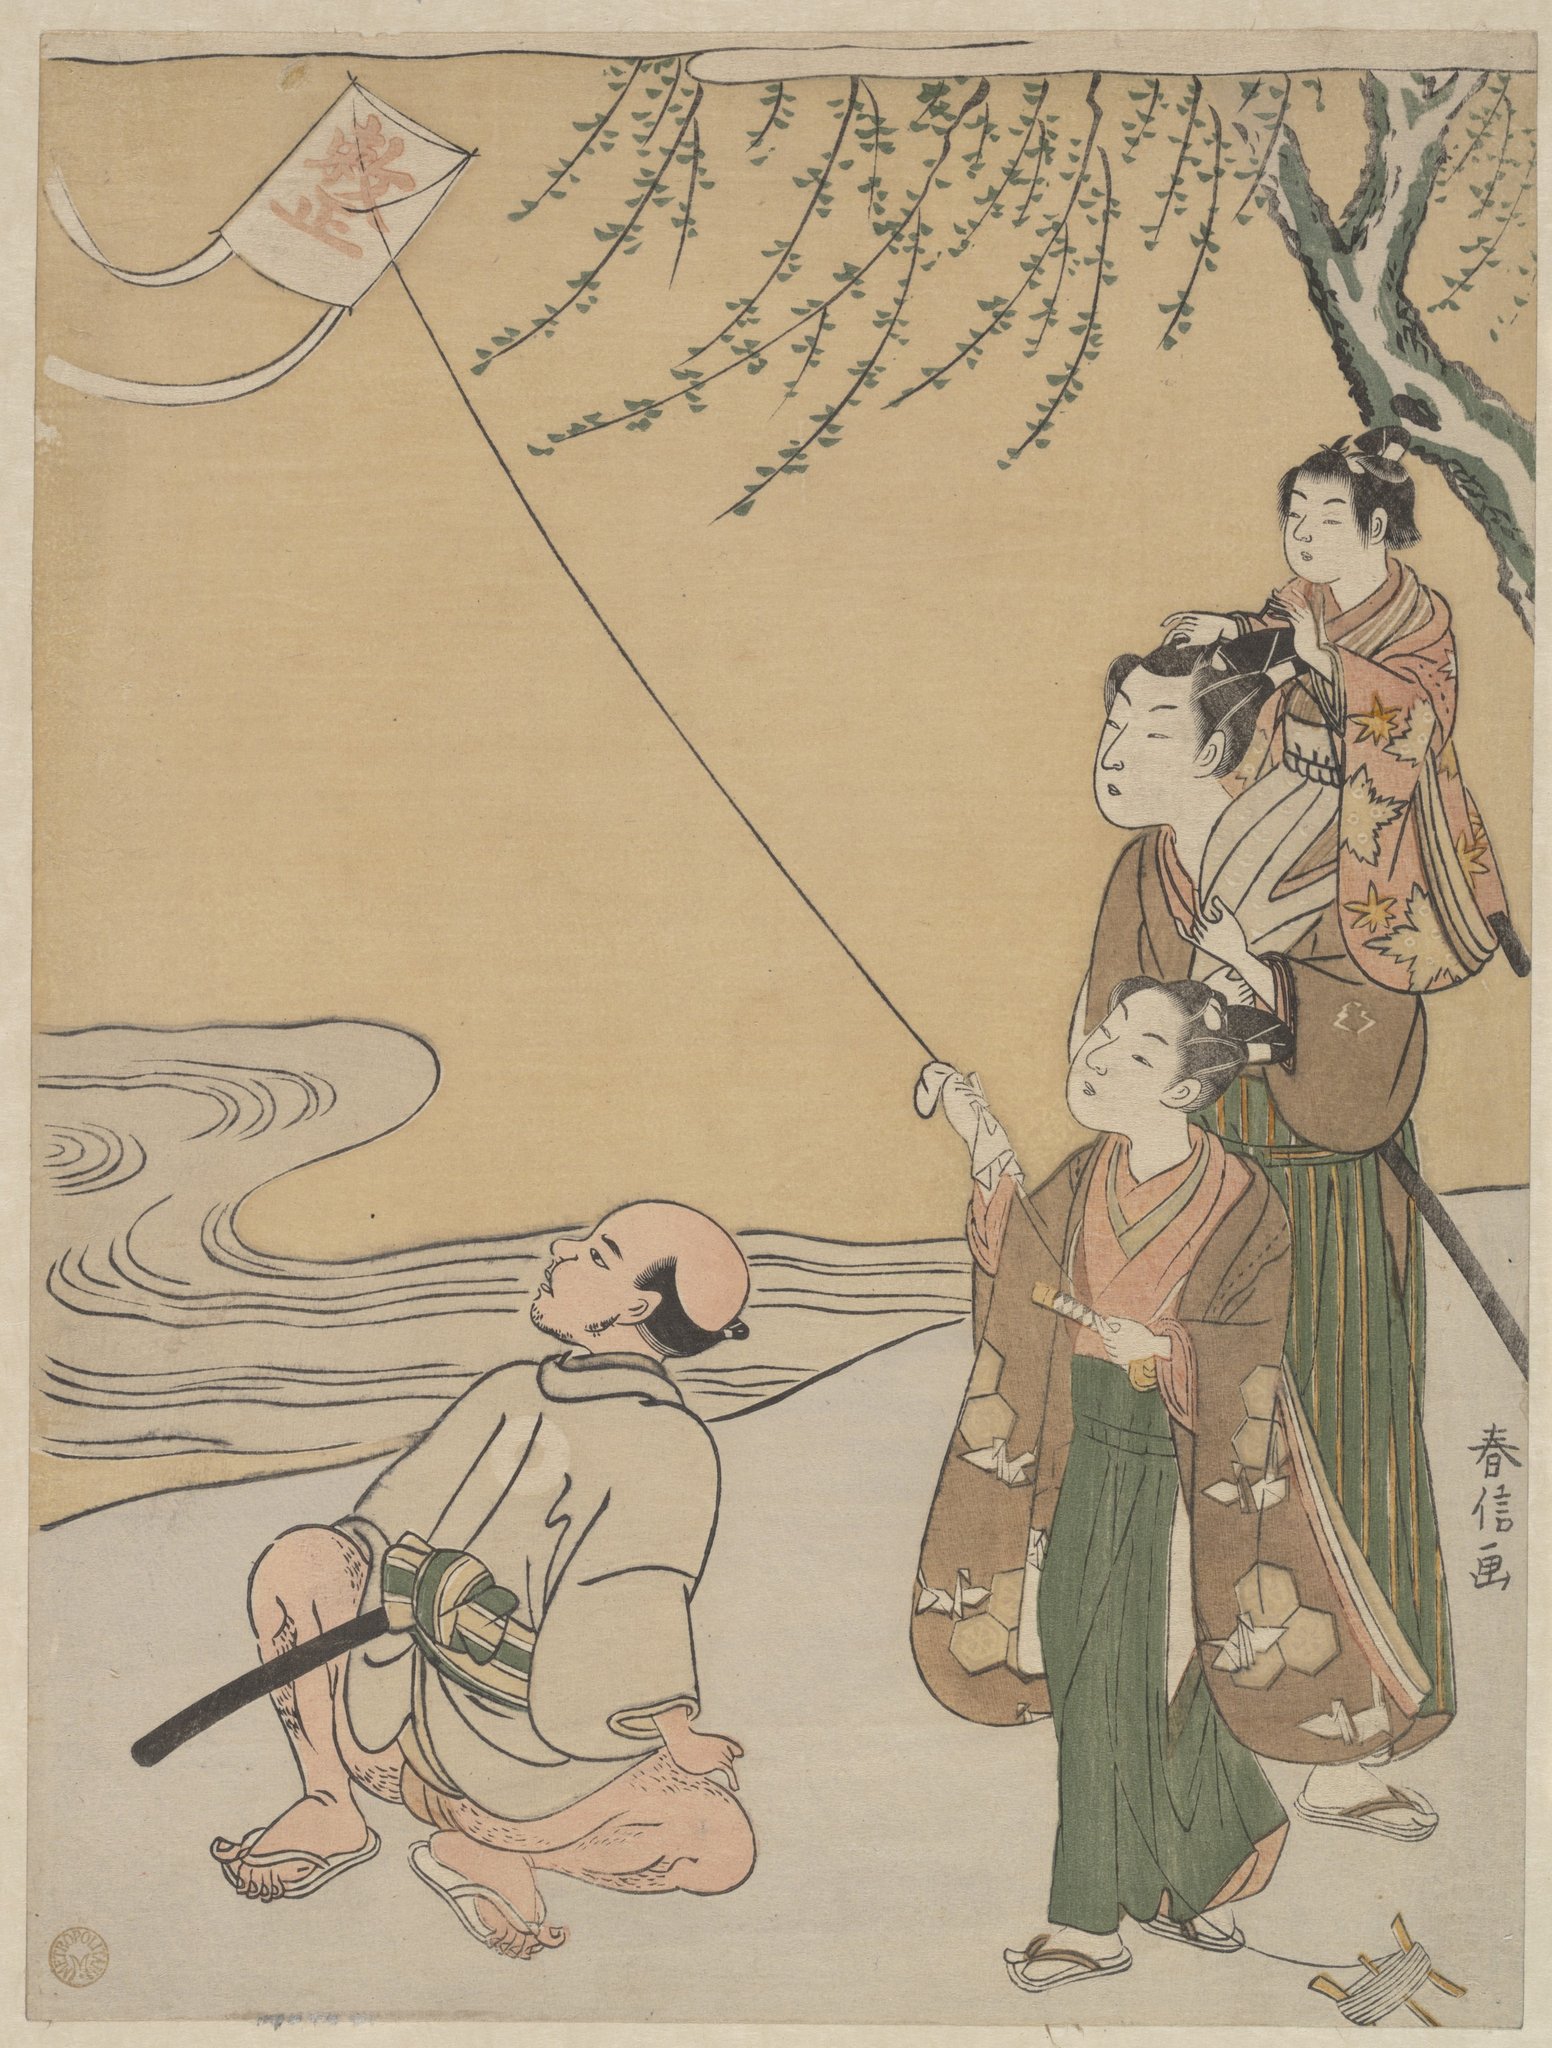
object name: print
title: Kite Flying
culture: japanese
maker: suzuki harunobu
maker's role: artist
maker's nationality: japanese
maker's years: 1725-1770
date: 1766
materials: ink, paper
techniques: woodblock print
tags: children,men,women,kites